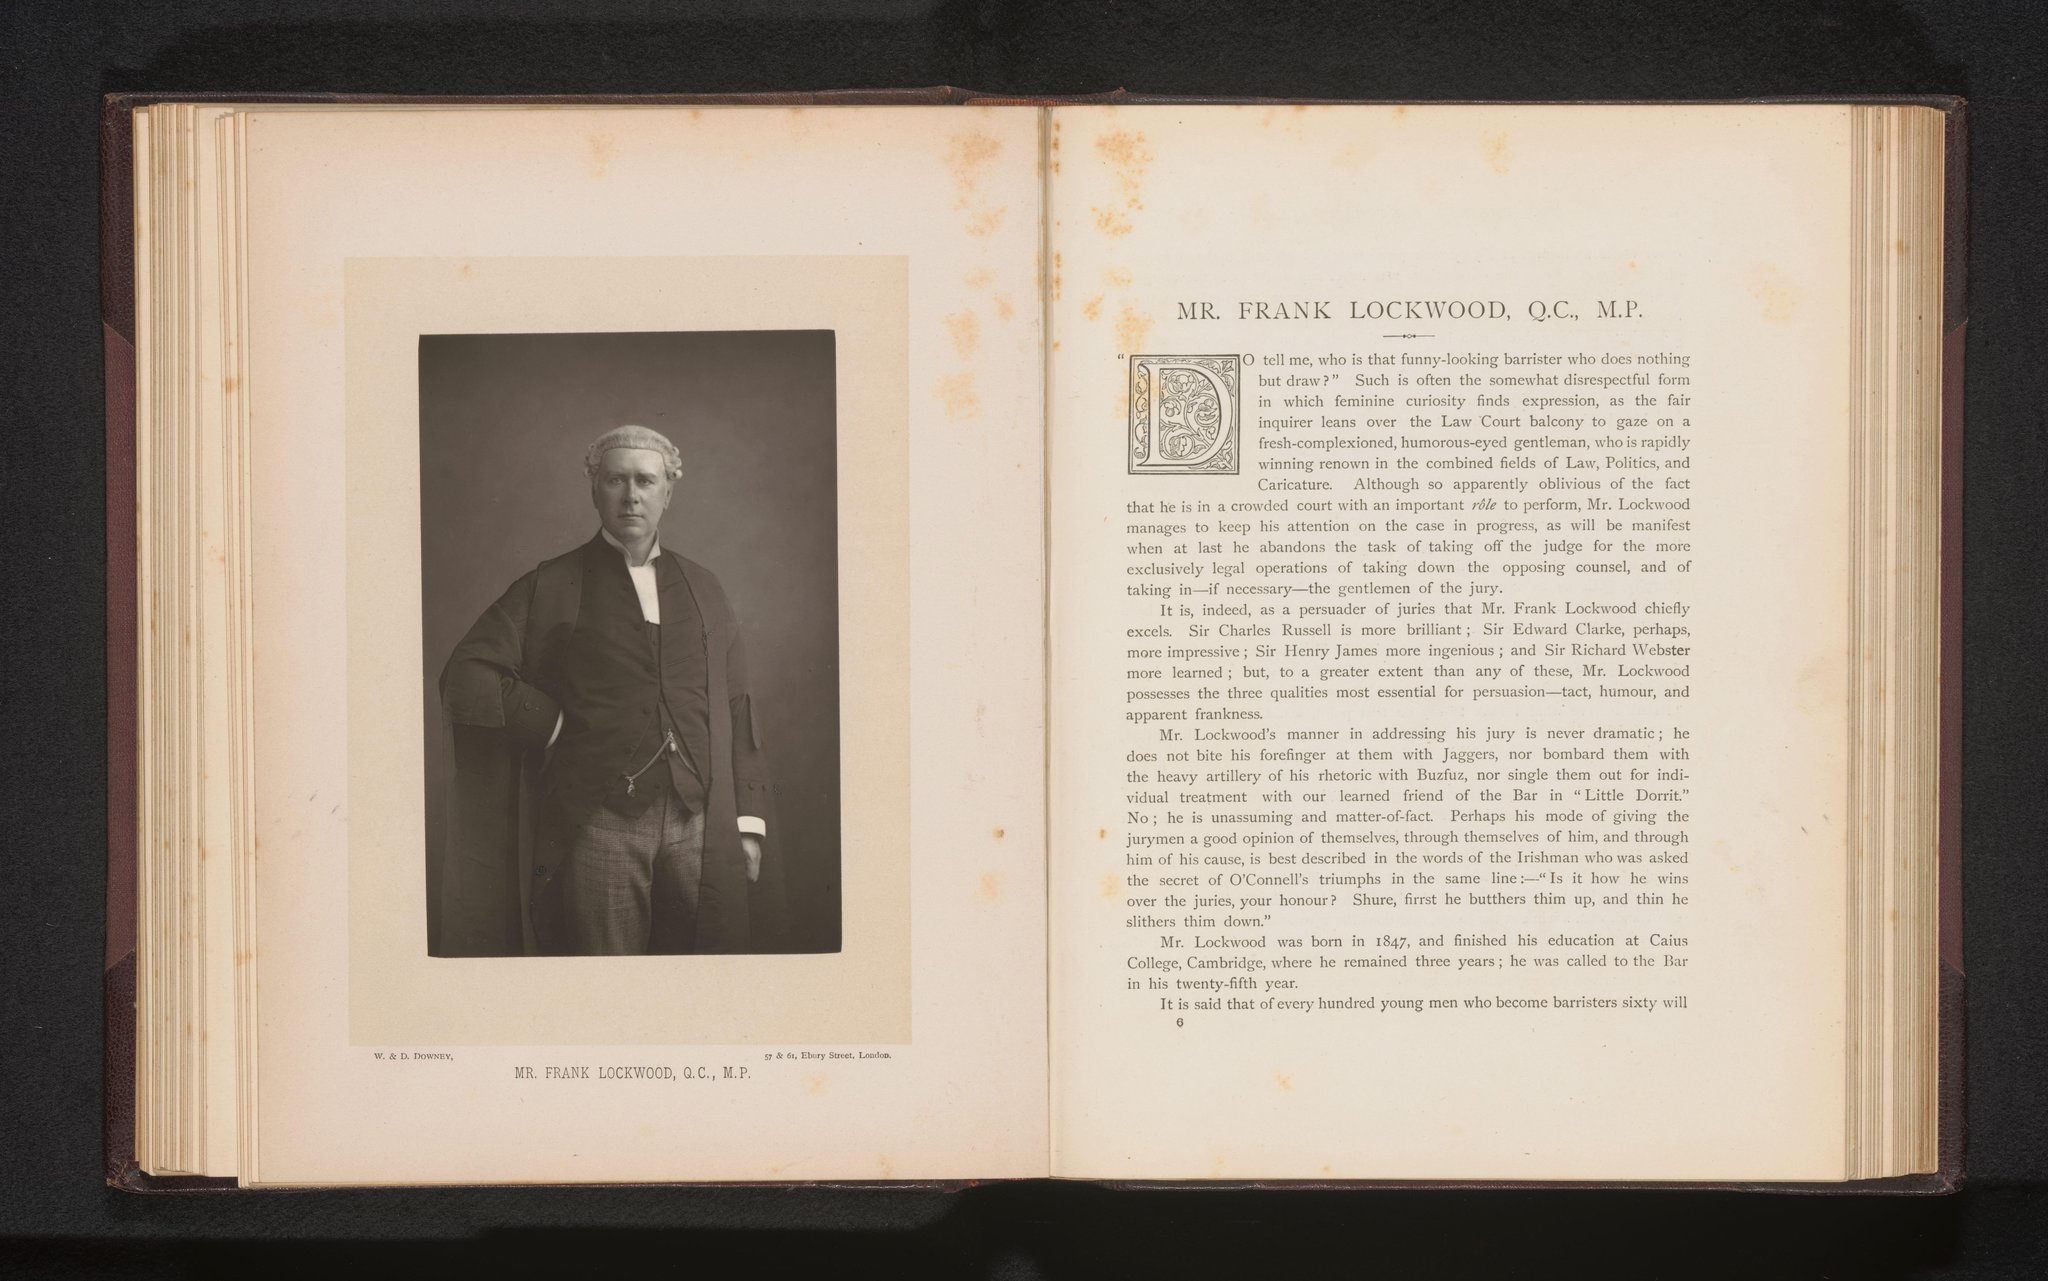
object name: photograph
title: Mr. Frank Lockwood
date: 1885-1890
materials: paper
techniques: carbon print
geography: london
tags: politician, historical persons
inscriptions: address: ‘57 & 61, Ebury Street, London.’